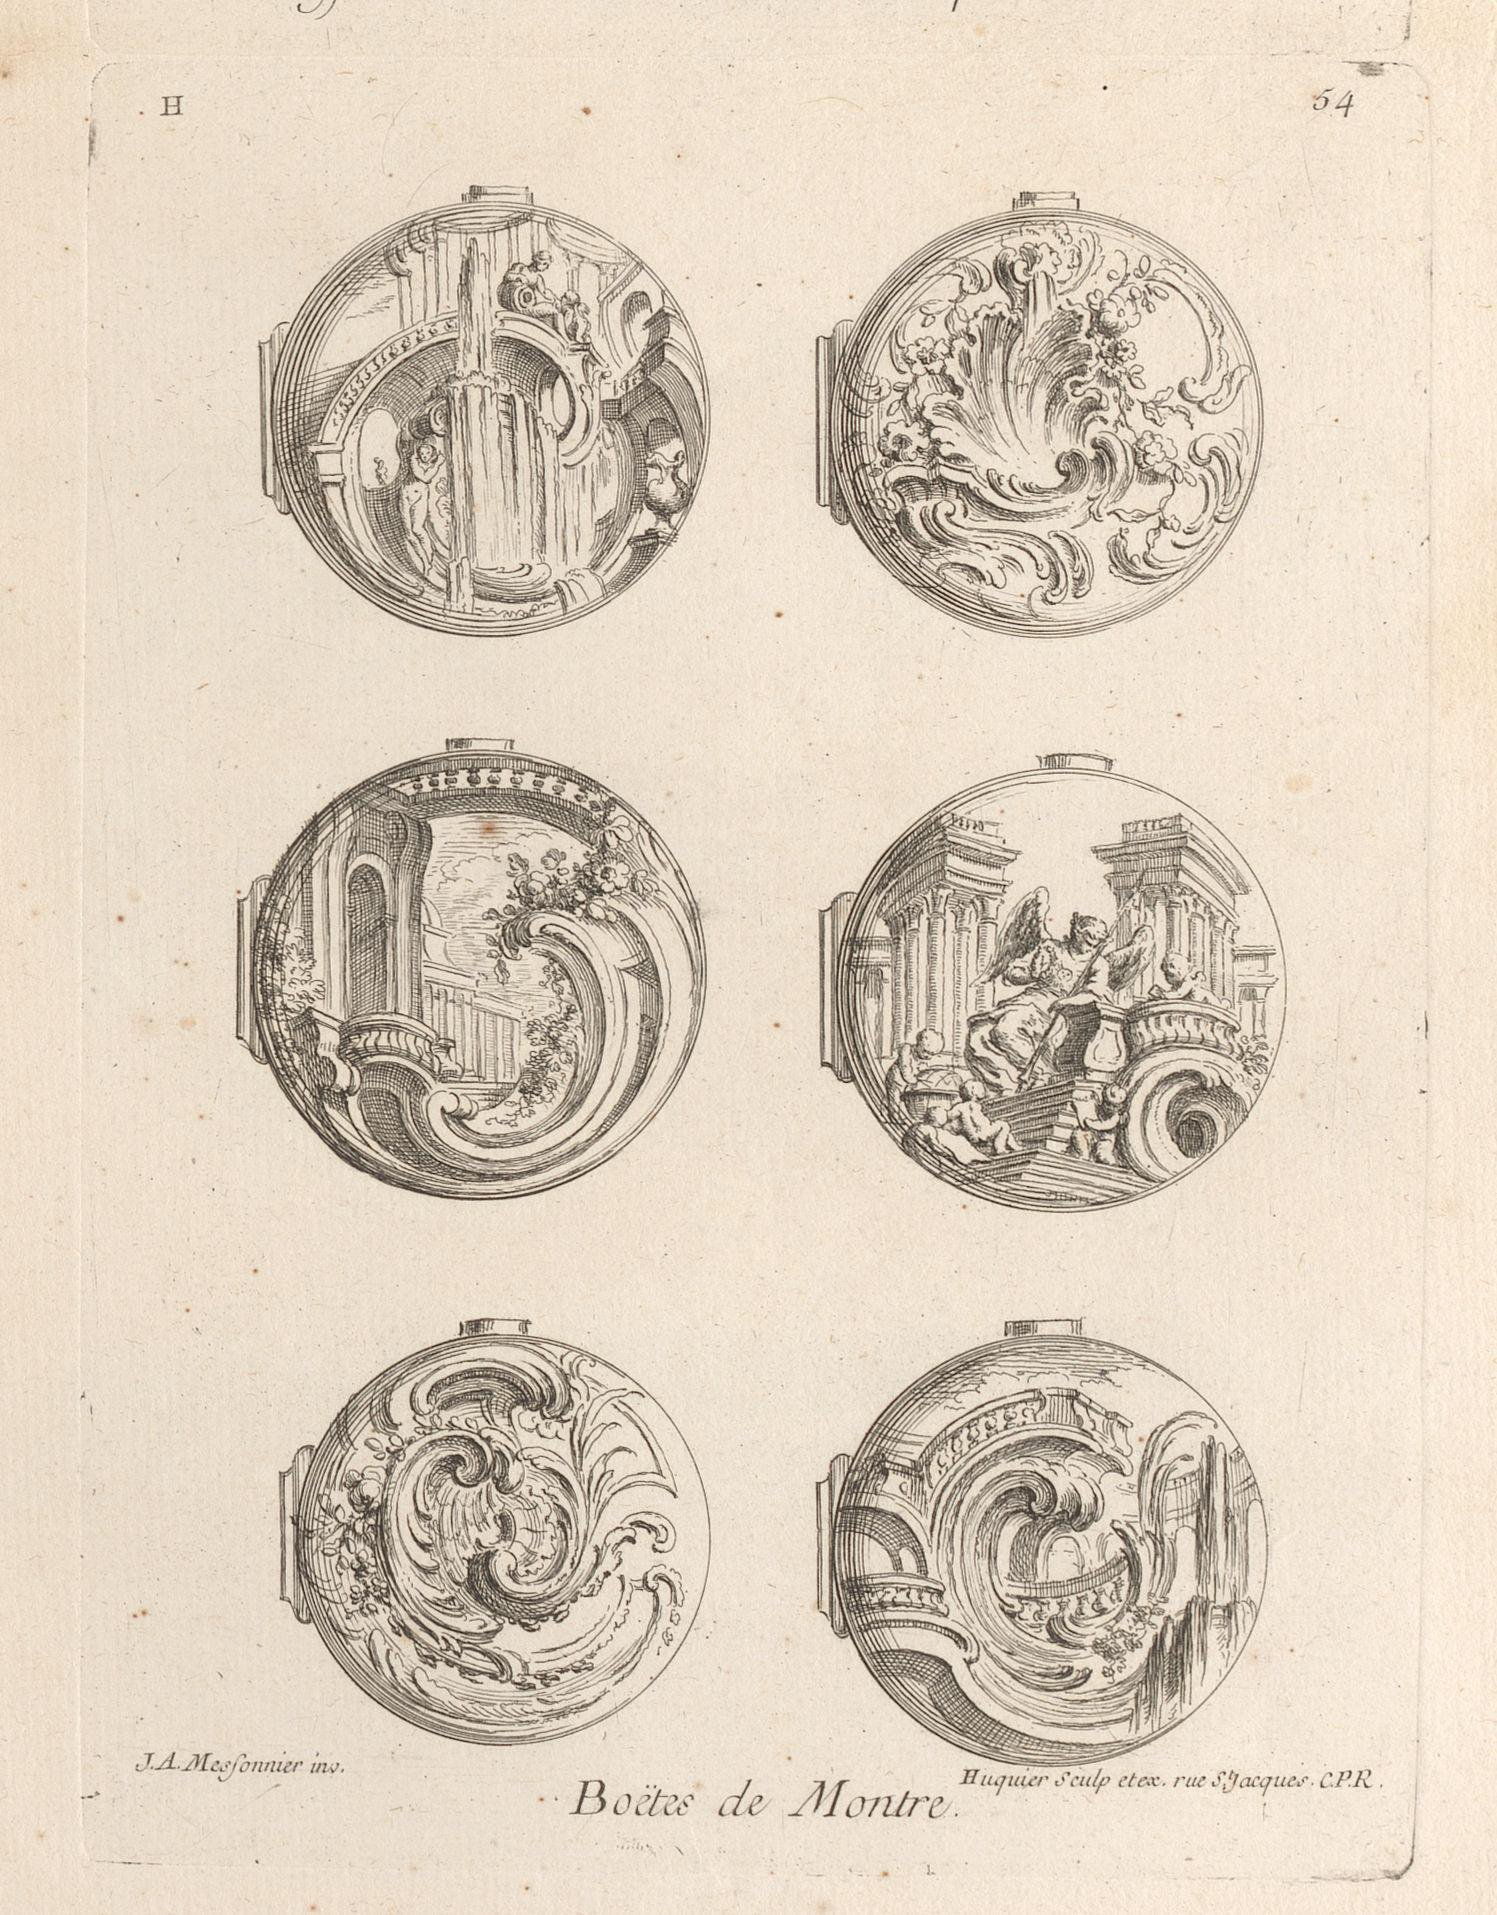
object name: ornament print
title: Boëtes de montre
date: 1738-1749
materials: paper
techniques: etching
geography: paris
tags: work of applied art, watch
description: Deze prent maakt deel uit van de serie "Huitième livre des oeuvres de mr. Messonnier", een van de delen van de monumentale serie "Oeuvre de Juste Aurele Meissonnier".